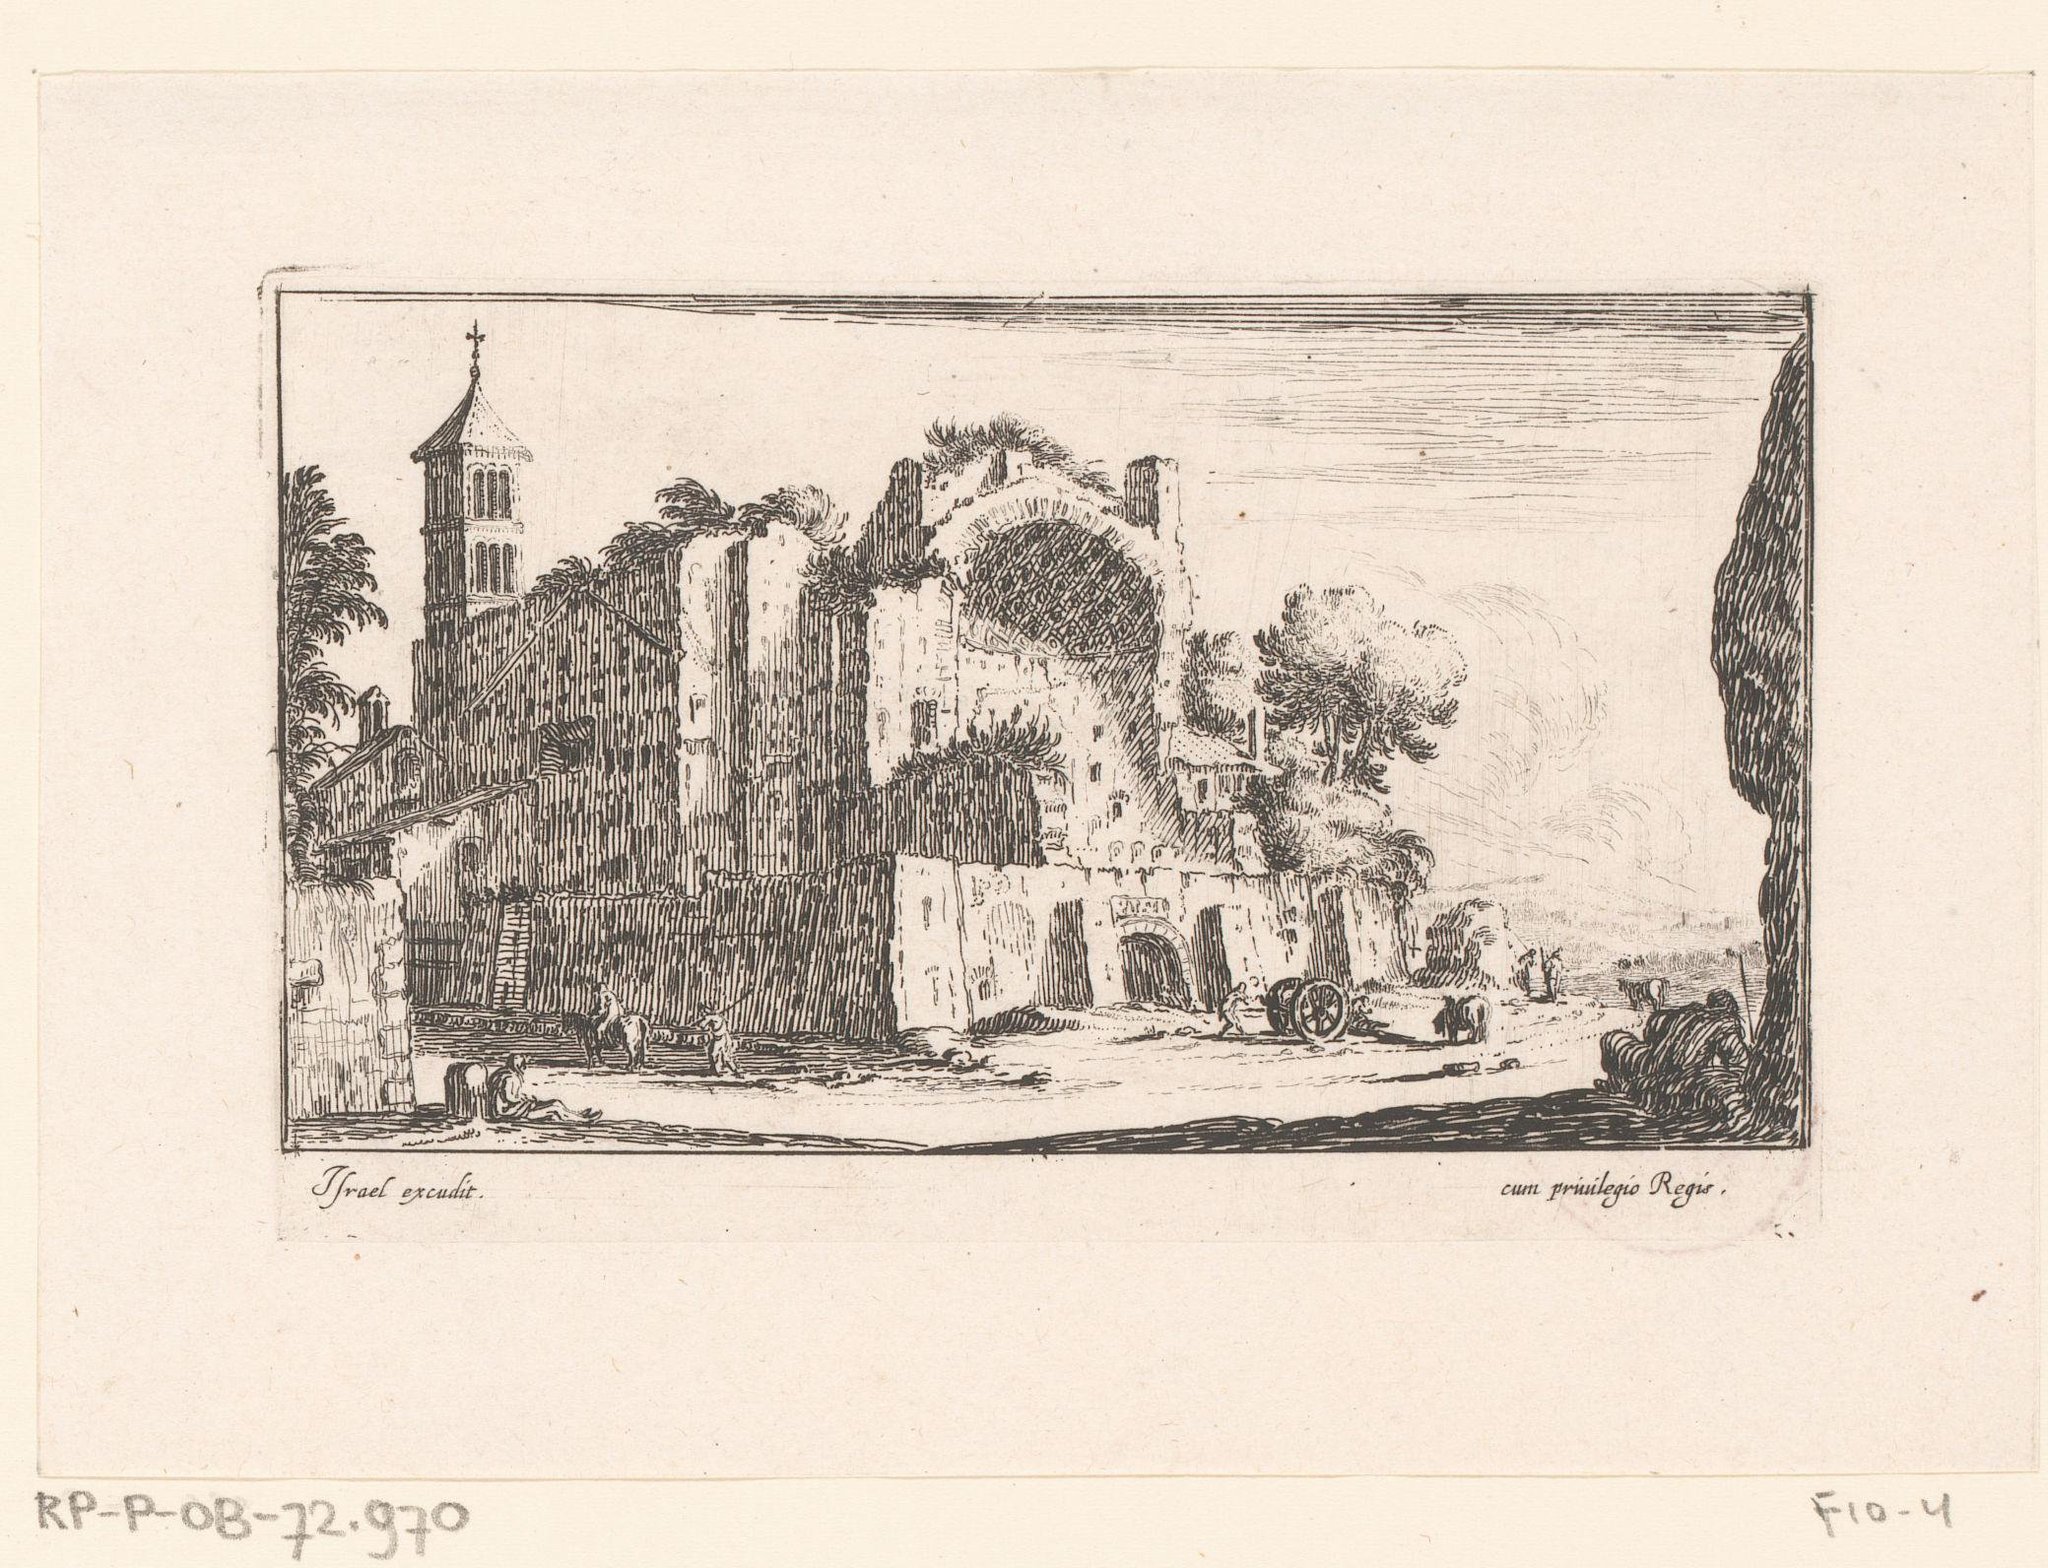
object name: print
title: Vues d'Italie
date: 1643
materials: paper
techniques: etching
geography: france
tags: landscape with ruins, temple, shrine ~ roman religion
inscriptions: collector's mark: Lugt 240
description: Prent maakt deel uit van een ongenummerde serie van acht prenten.